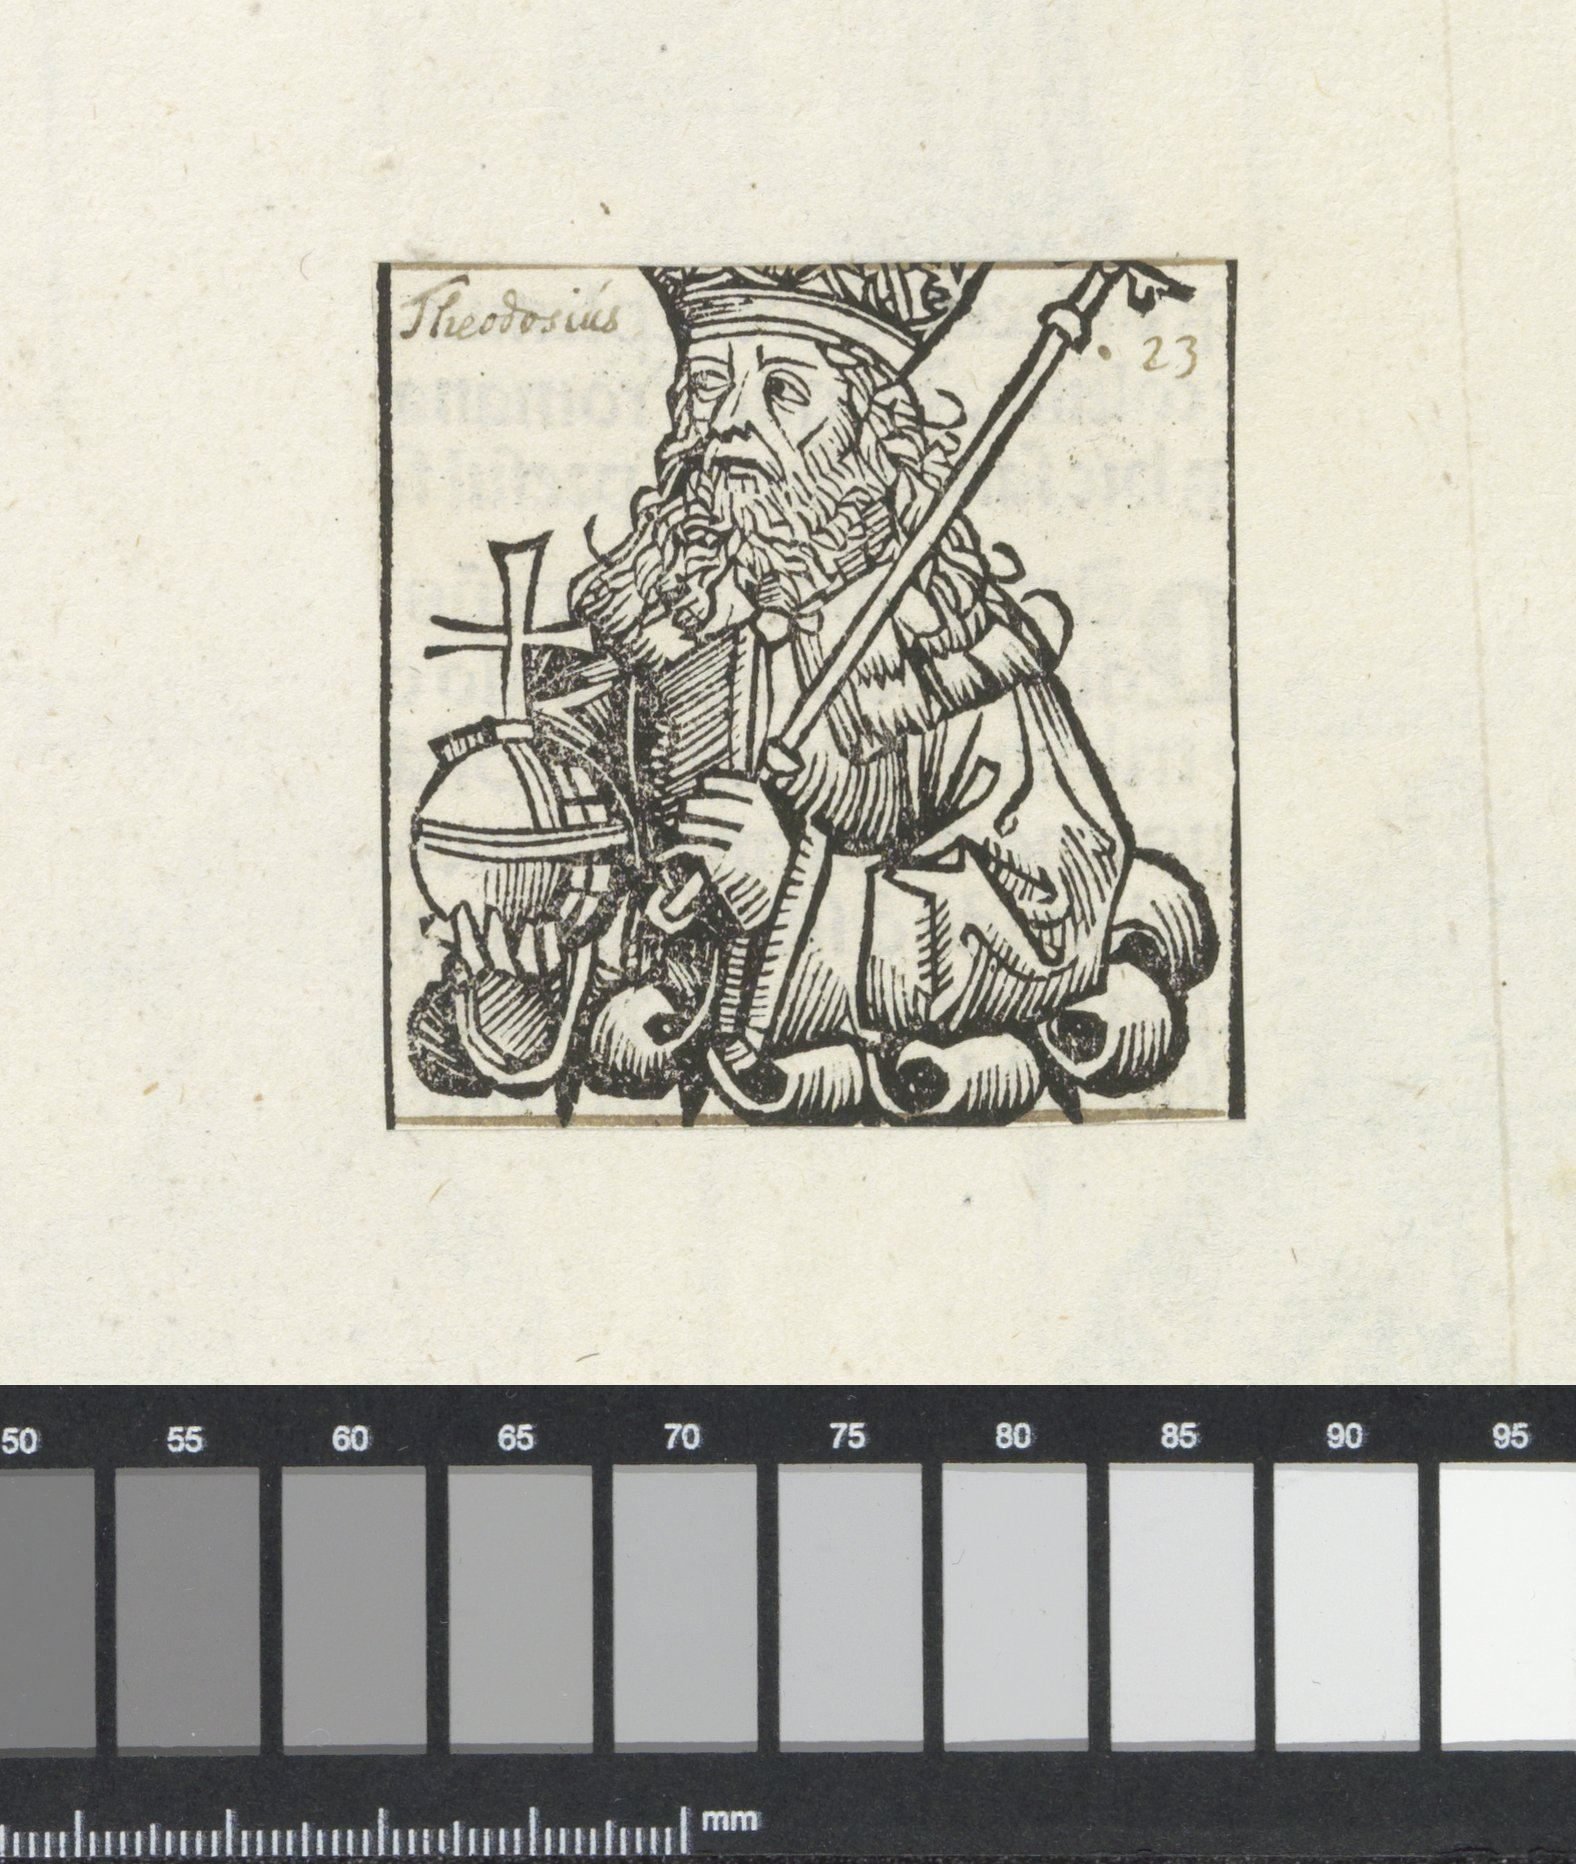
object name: print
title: Keizer Theodosius I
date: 1493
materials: paper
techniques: letterpress printing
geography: nuremberg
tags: emperor, king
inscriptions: inscription: ‘Theodosius / 23’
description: Een bloemkelk met een koning, naar links gericht. De man heeft een scepter en een rijksappel in zijn handen. De voorstelling is onderdeel van de opeenvolging Romeinse keizers in de Liber Chronicarum. De tekst identificeert de man als keizer Theodosius I. De prent maakt deel uit van een album.